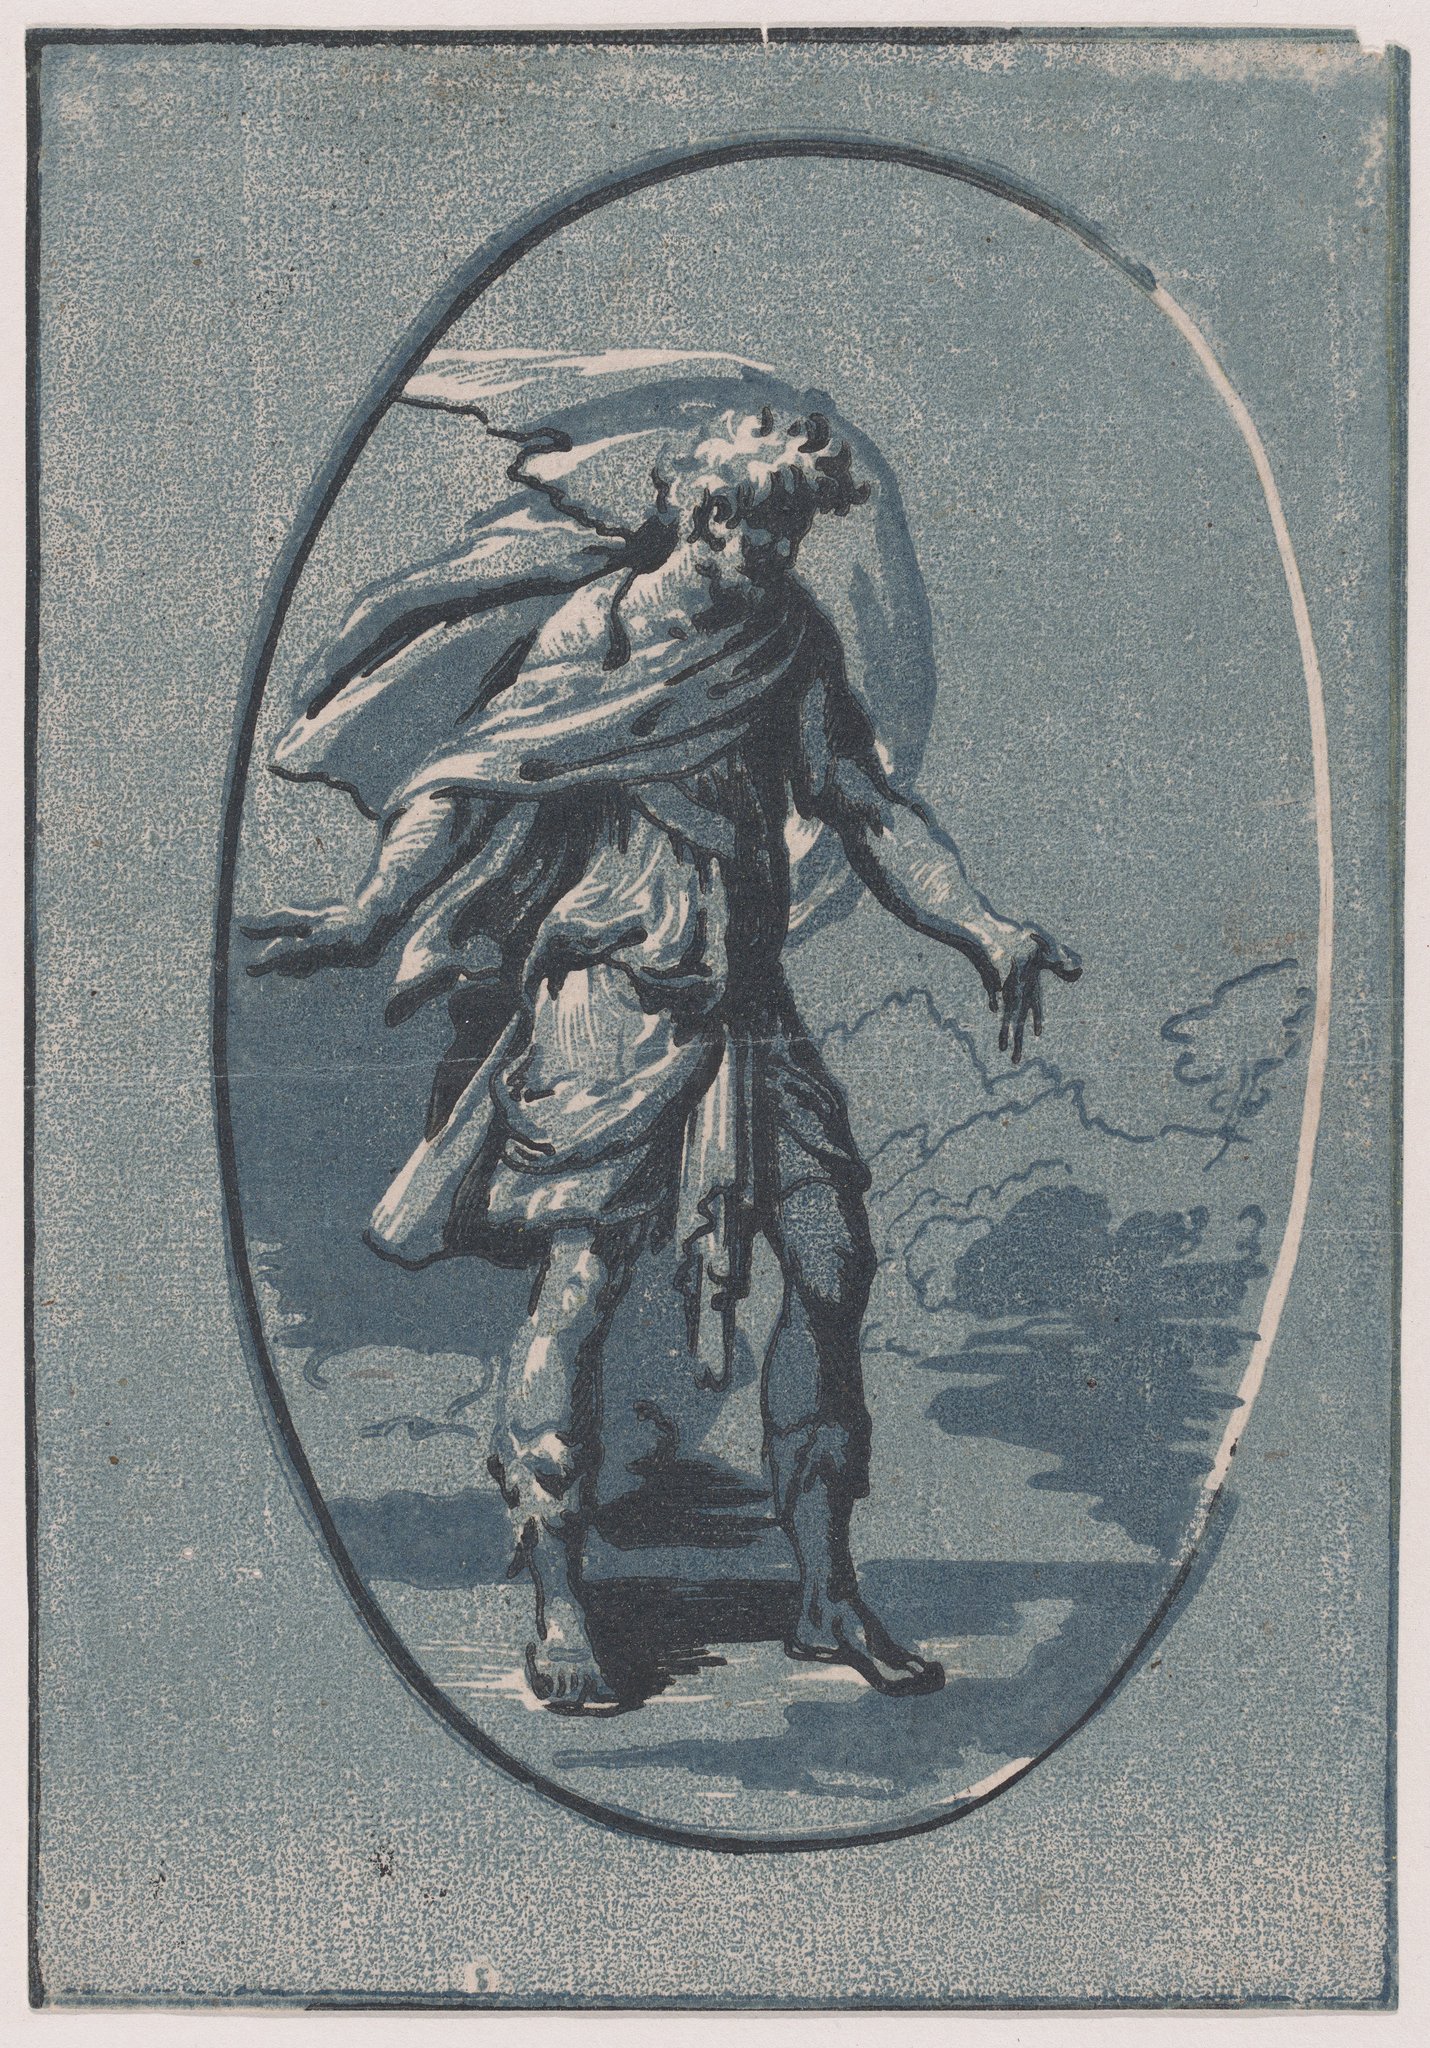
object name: print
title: Olympus (Surprise)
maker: niccolò vicentino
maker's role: artist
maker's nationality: italian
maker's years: 1510-1550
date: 1540-1550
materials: ink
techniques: woodcut, printing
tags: men